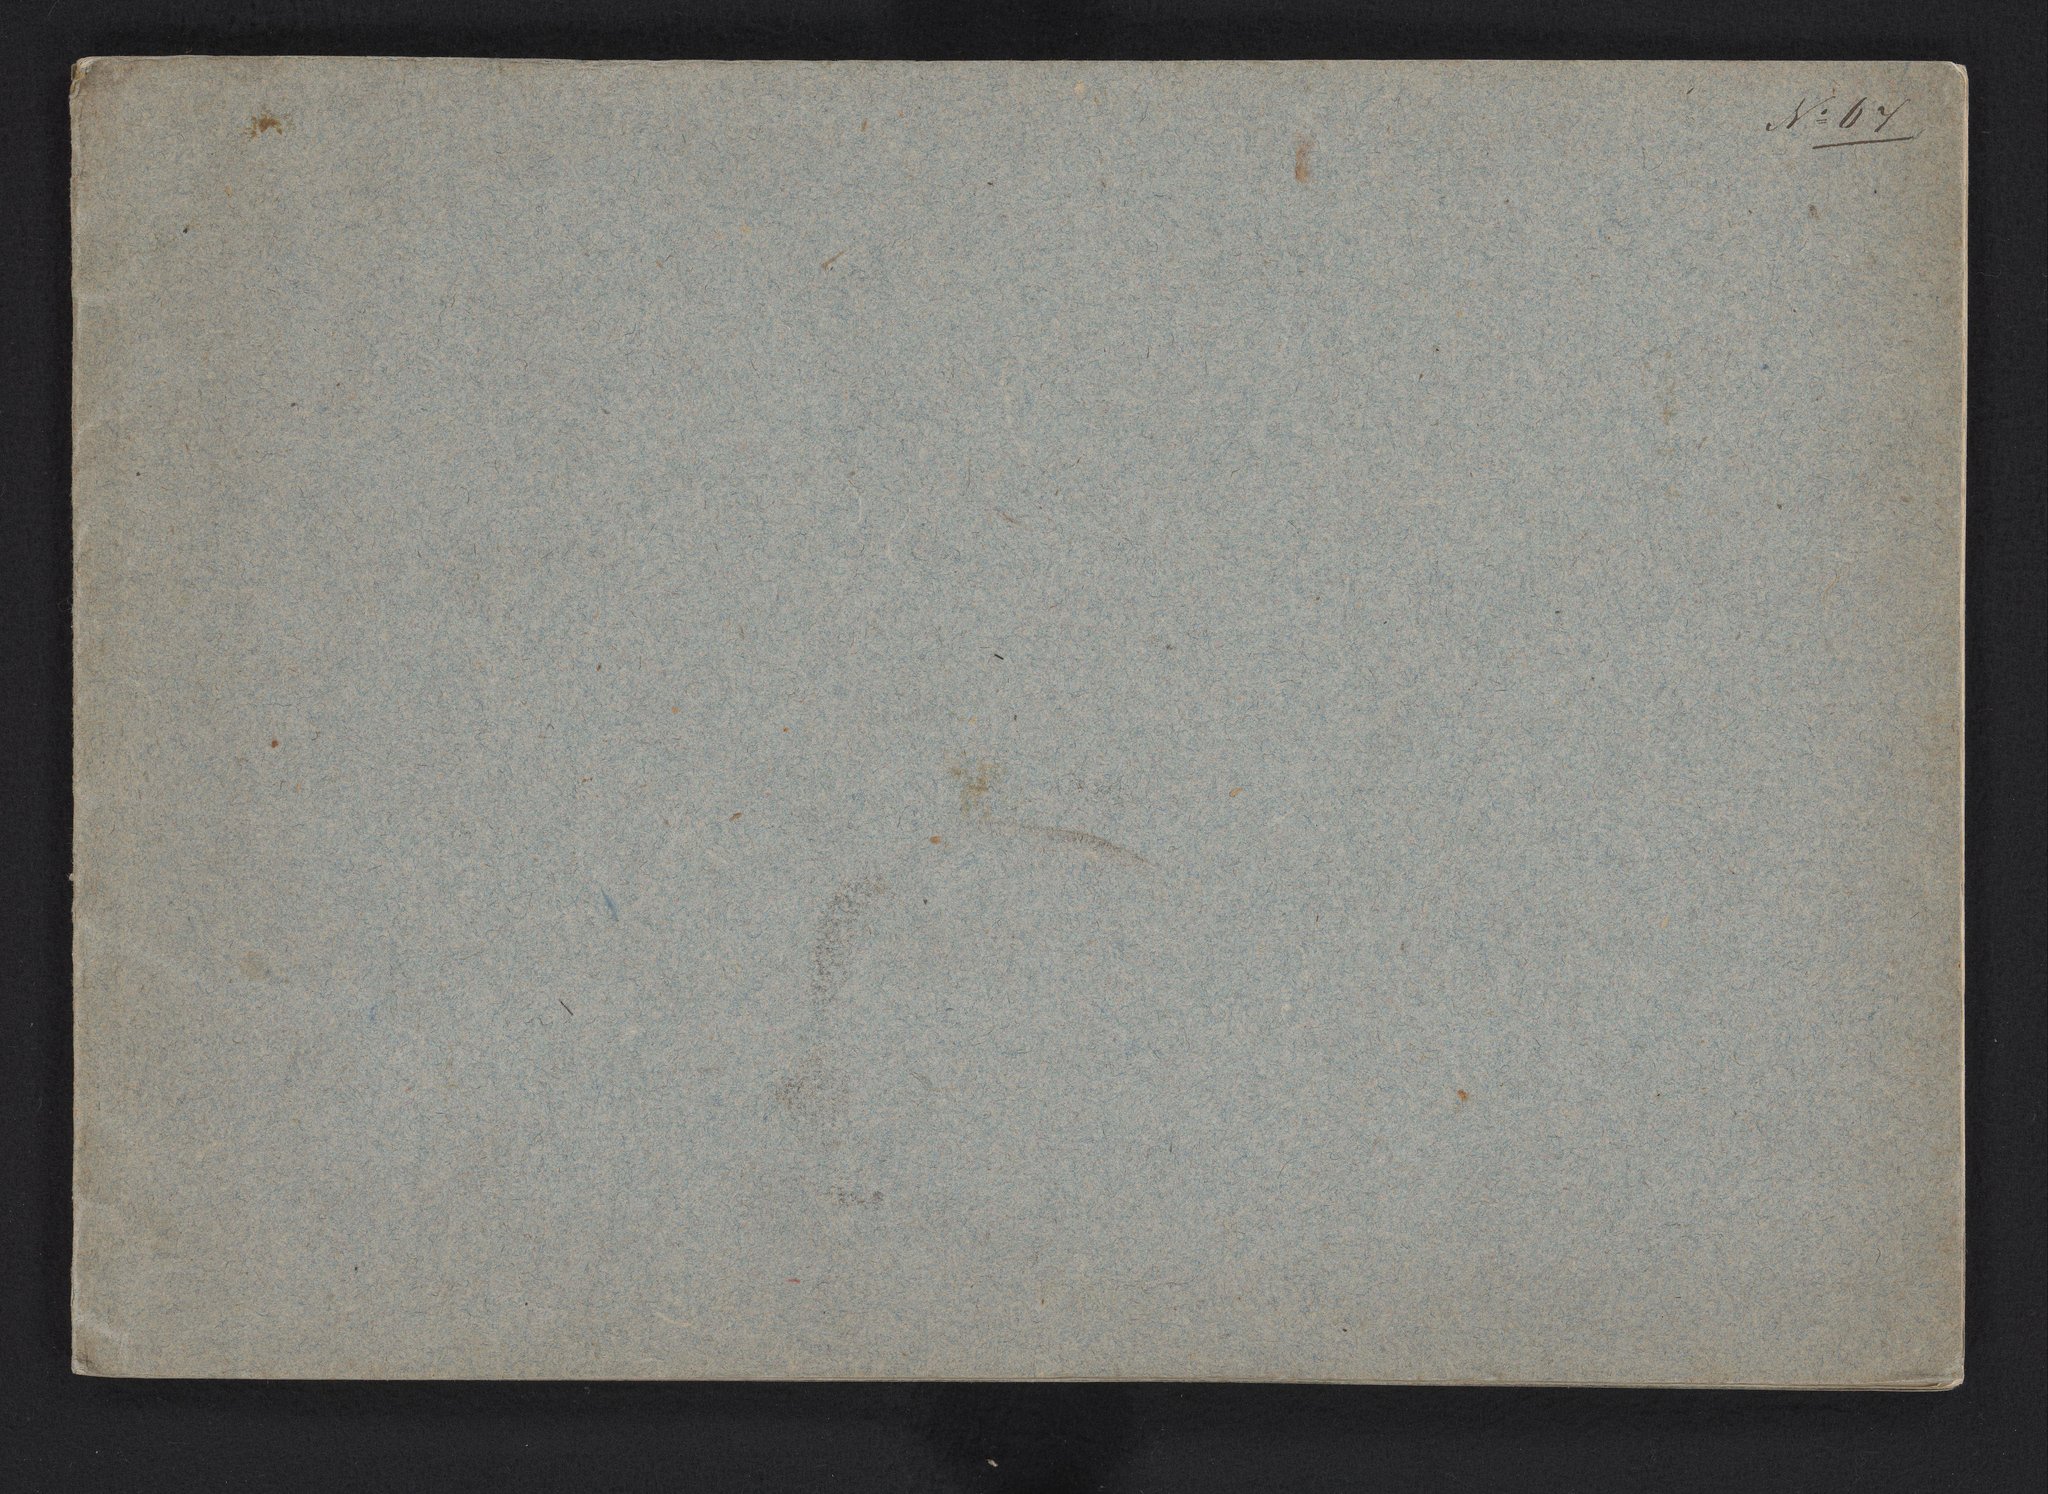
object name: prentrecueil, prentenalbum, prentalbum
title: Prentalbum met klassieke ornamenten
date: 1817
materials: paper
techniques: etching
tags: ornaments ~ art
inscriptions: number: ‘N. 64’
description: Prentalbum met een serie van zes ornamenten. Schrift met blauwe omslag waarin prenten gebonden.